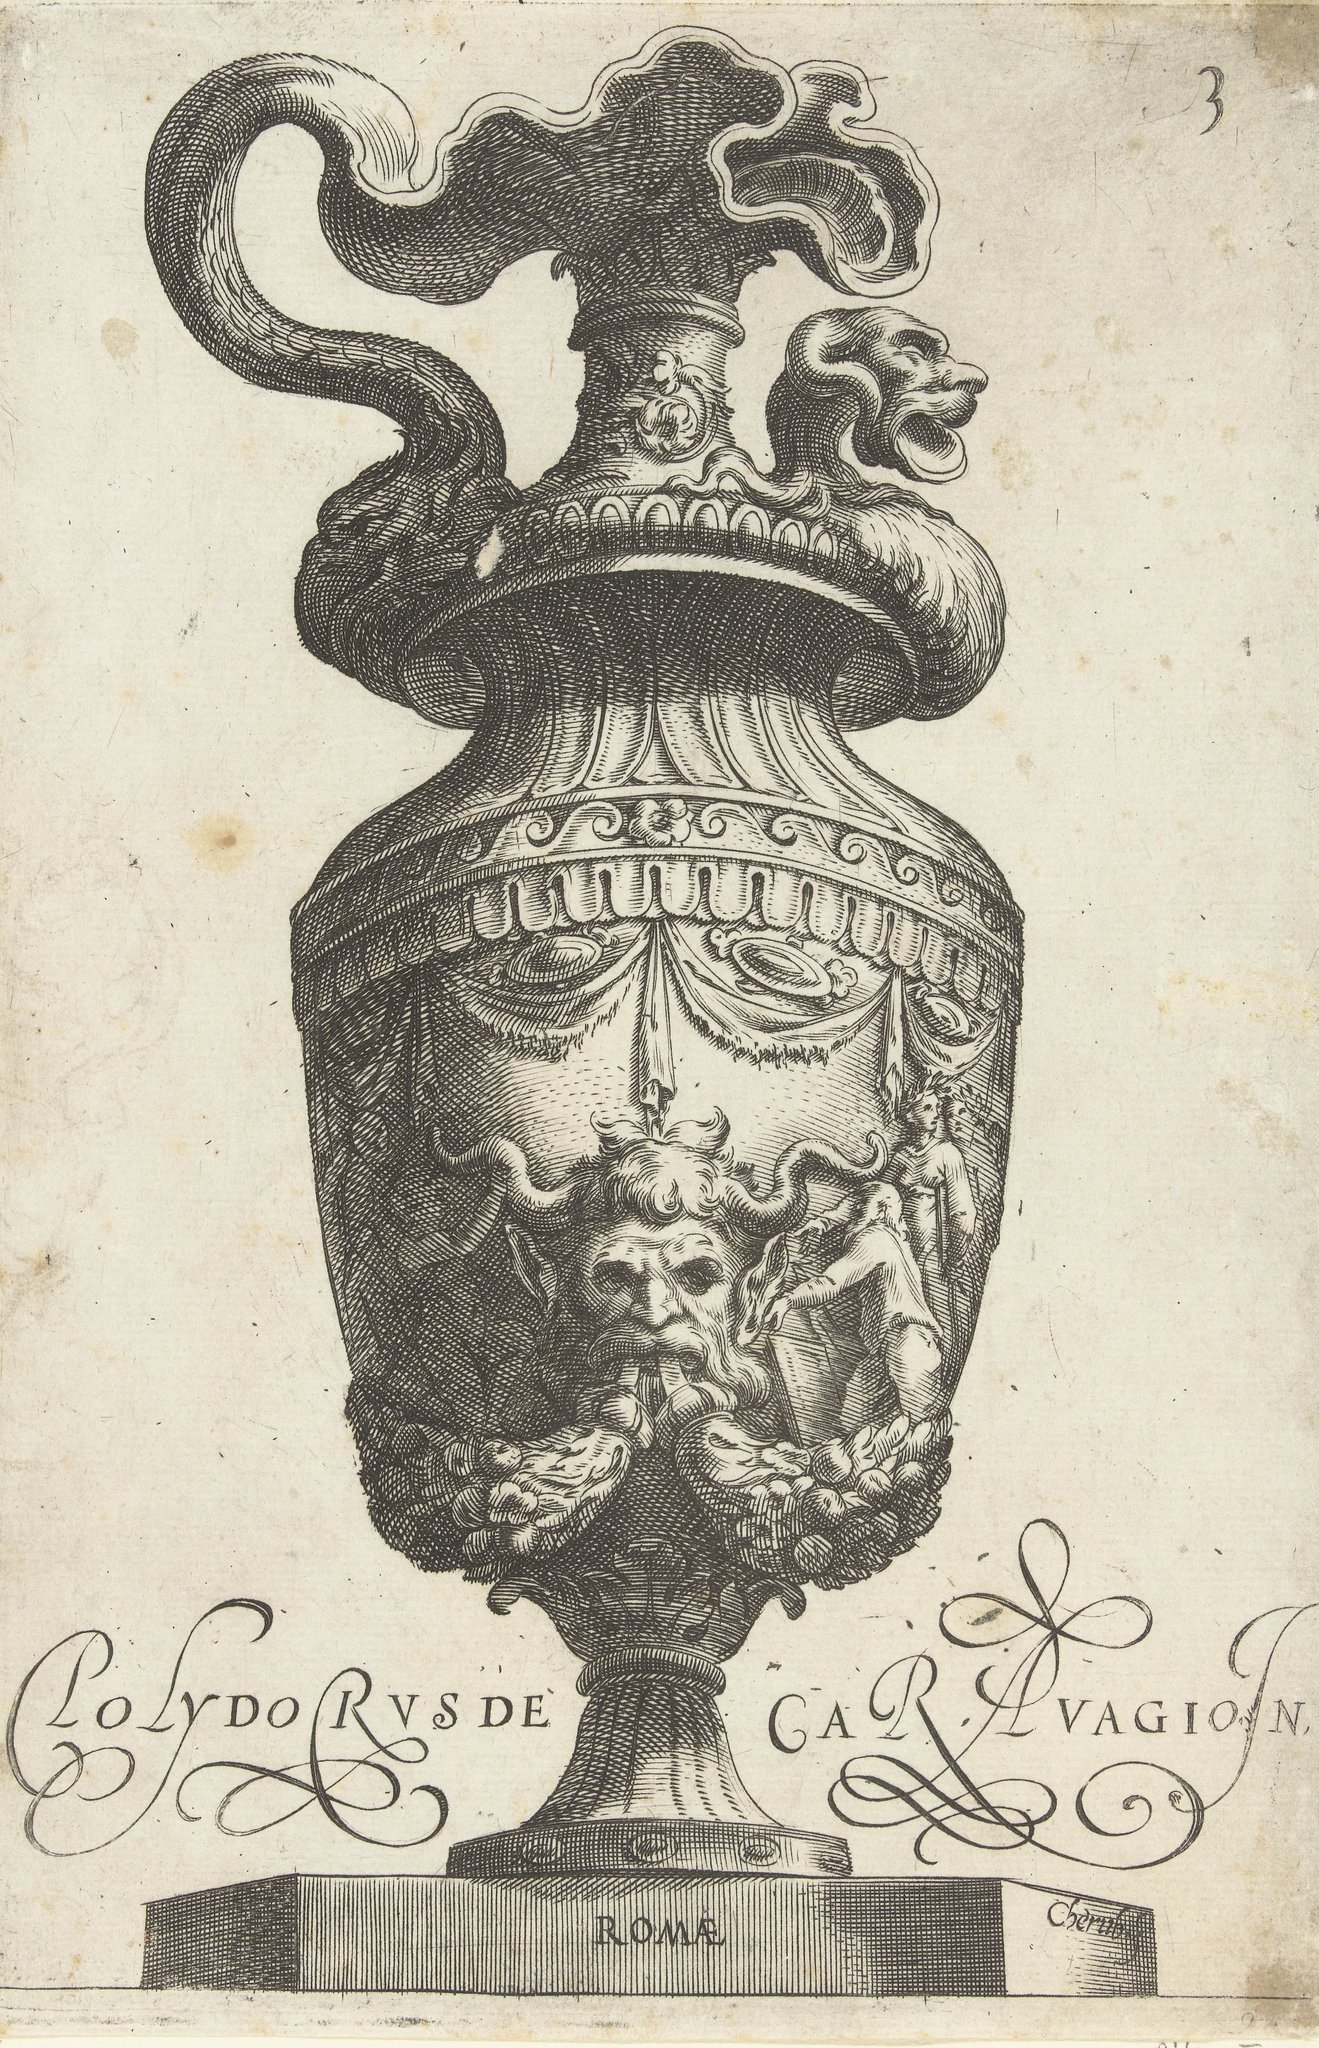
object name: ornament print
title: Vasa a Polydor (...)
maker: cherubino alberti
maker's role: draughtsman, print maker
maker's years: 1553-1615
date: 1563-1582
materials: paper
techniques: engraving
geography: italy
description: De buik van de kan is gedecoreerd met een mascaron met horens, hij heeft de uiteinden van twee guirlandes in zijn mond. Uit serie van 10 bladen.